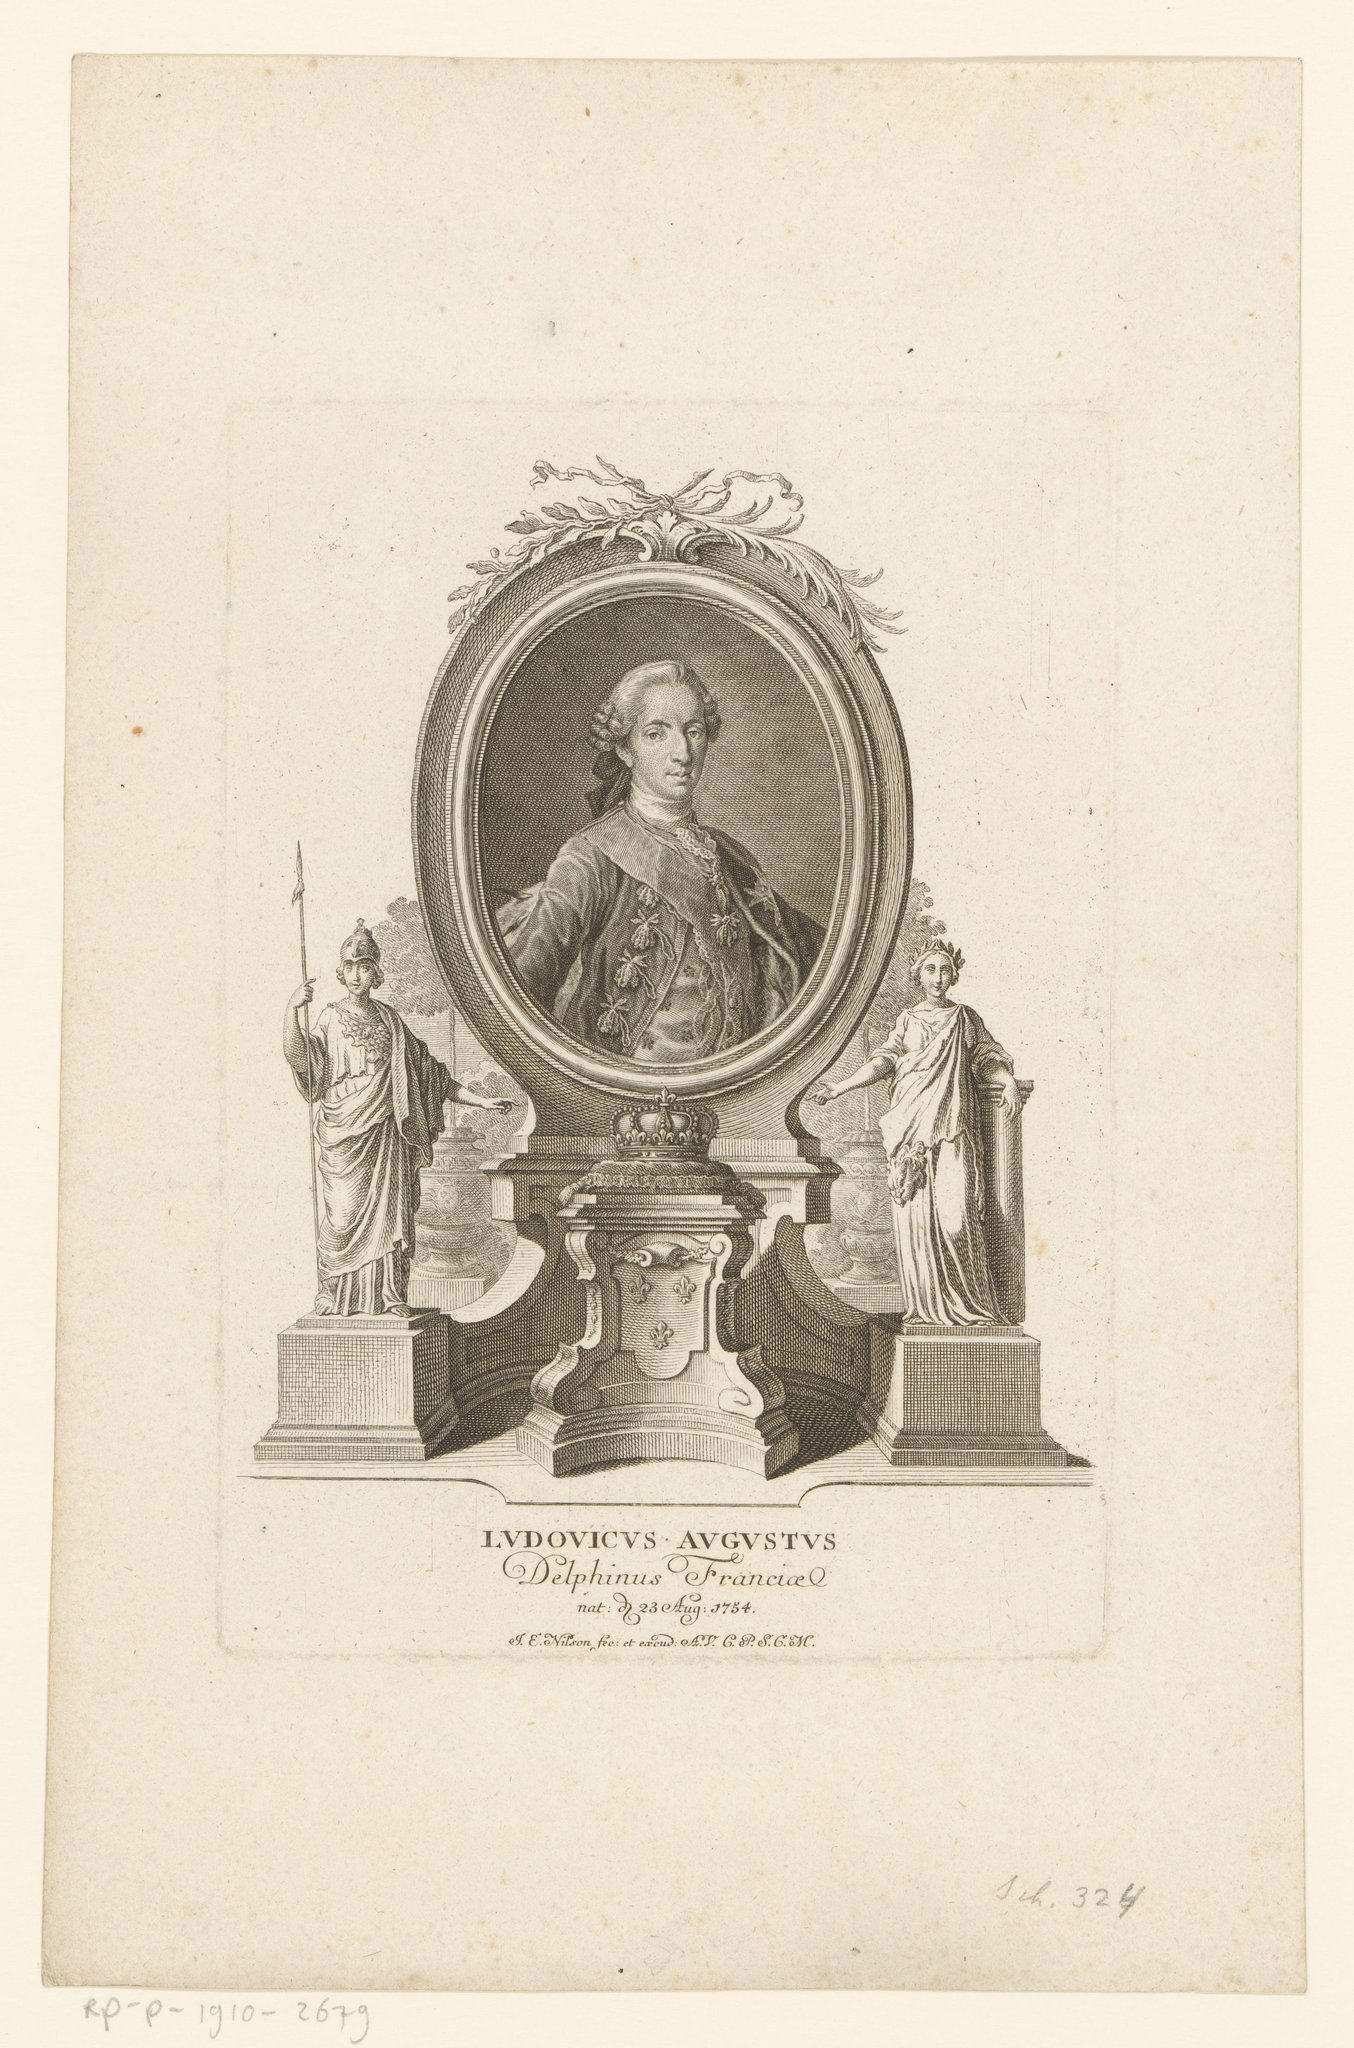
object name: print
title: Portret van Lodewijk XVI, koning van Frankrijk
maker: johann esaias nilson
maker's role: draughtsman, print maker, publisher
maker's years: 1721-1788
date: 1774-1788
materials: paper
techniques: engraving, etching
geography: augsburg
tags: paris, lodewijk xvi (koning van frankrijk), attributes of hercules, historical persons, attributes of minerva, baton of general, insignia and symbols of sovereignty (crown, diadem, sceptre, orb, seal, standard, cloak, pectoral)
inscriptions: collector's mark: Lugt 2228